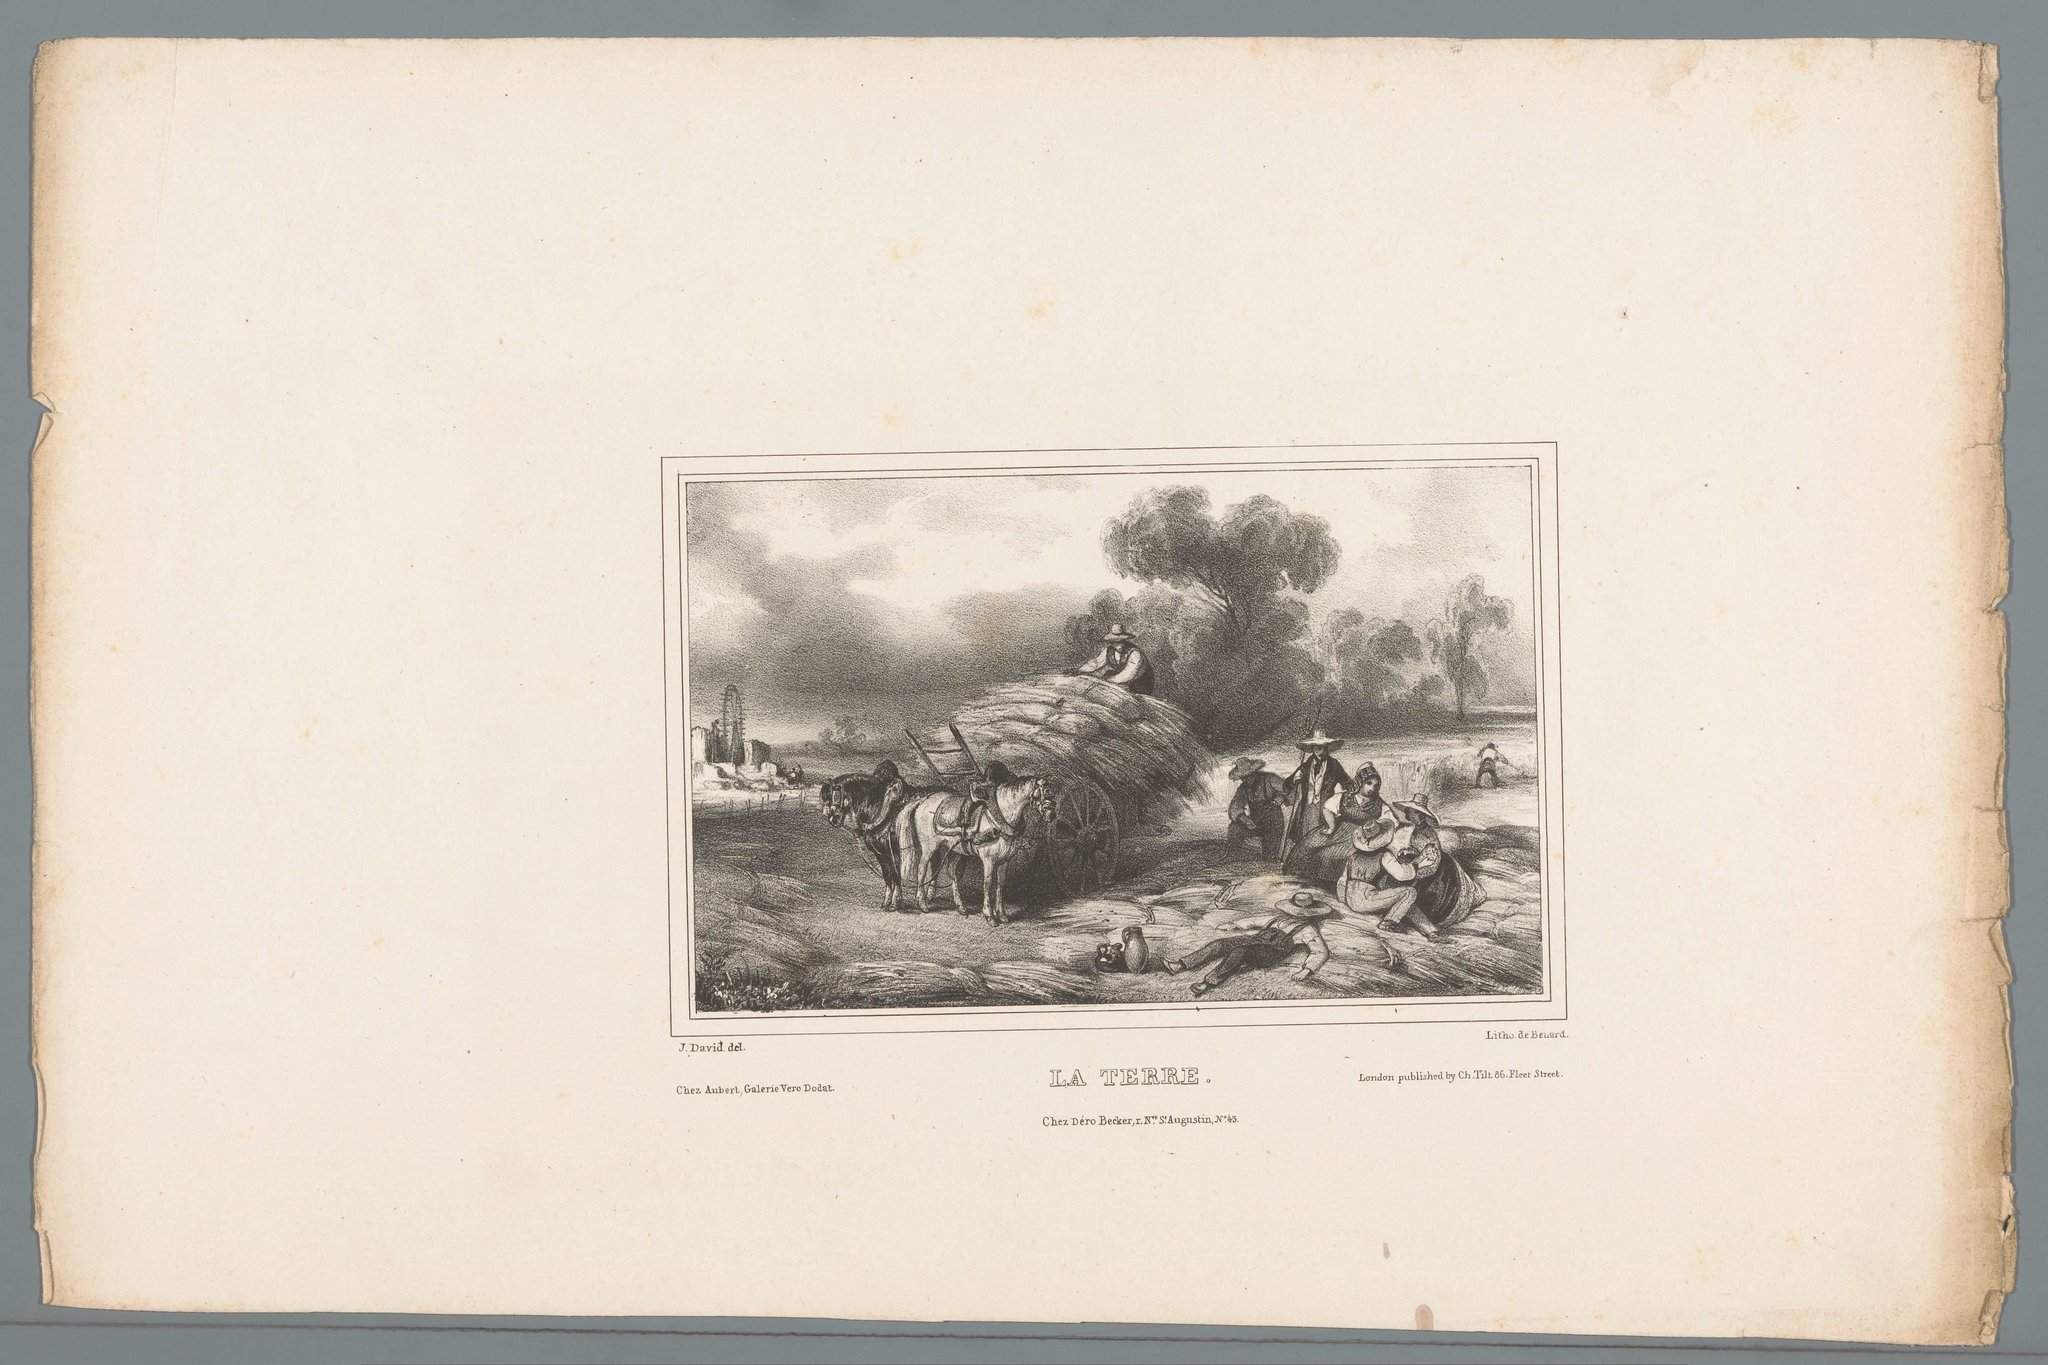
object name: print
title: Maaiers rusten tijdens de oogst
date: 1840-1850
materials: paper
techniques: lithograph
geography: london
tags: two-wheeled vehicle drawn by two animals, rest during harvest (eating, dancing, making love, etc.), reaping, picking, mowing ~ harvest